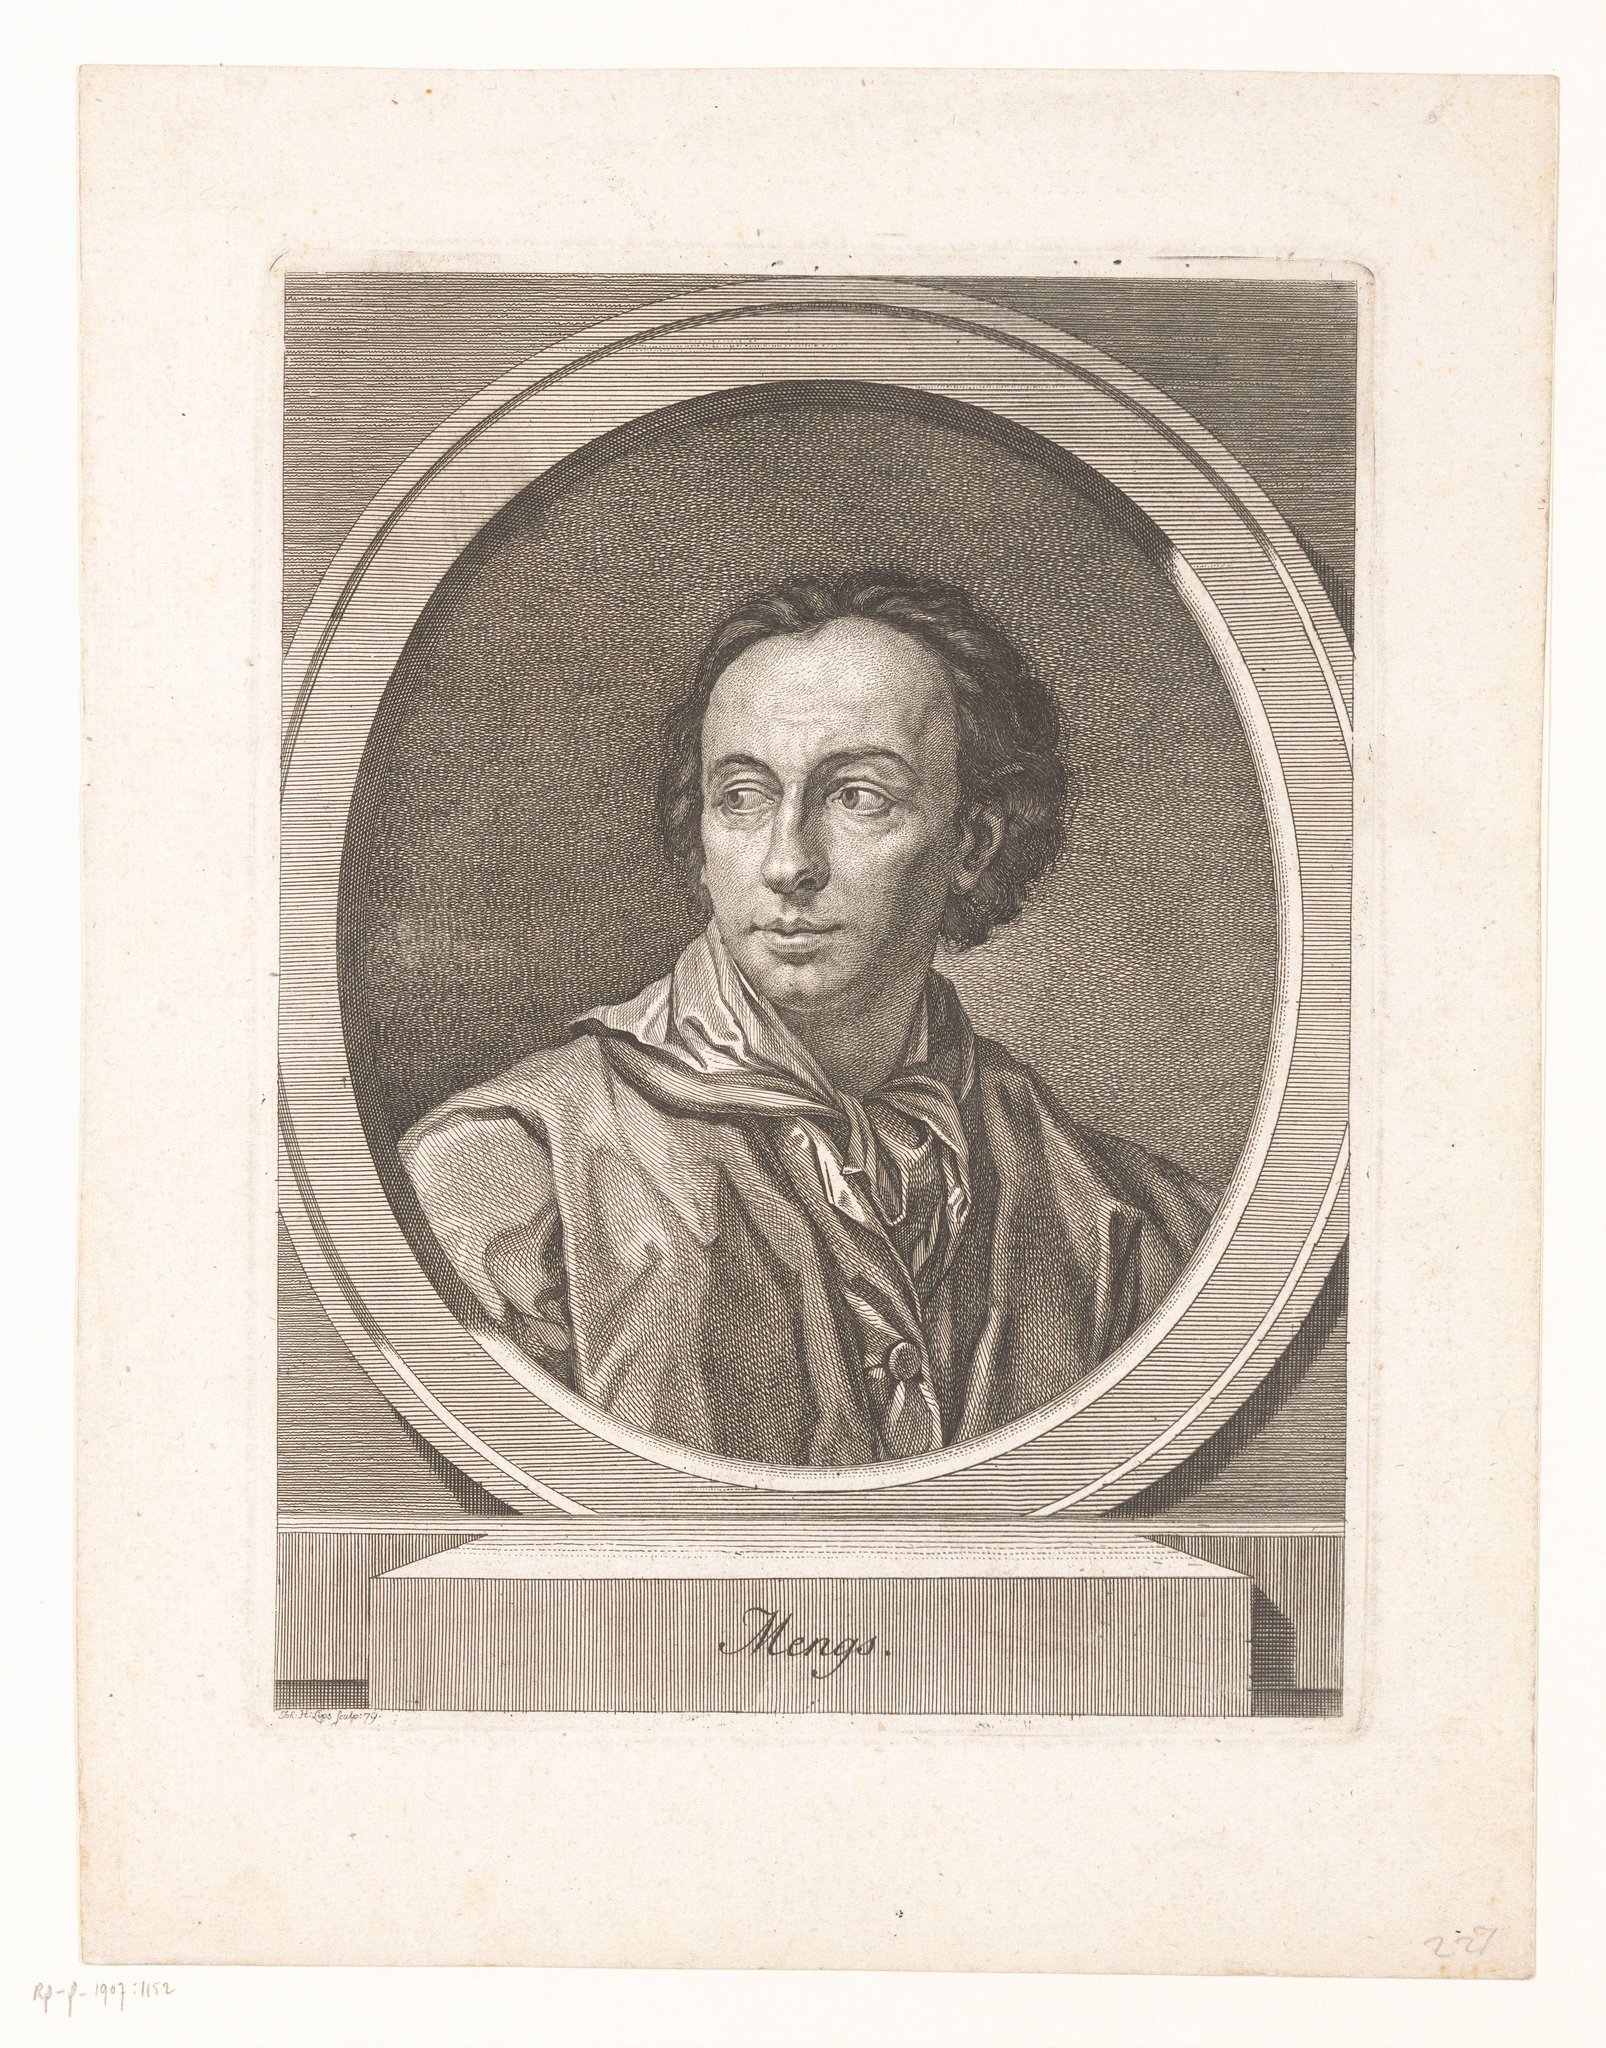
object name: print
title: Portret van Anton Raphael Mengs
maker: johann heinrich lips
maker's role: draughtsman, painter, print maker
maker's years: 1758-1817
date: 1779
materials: paper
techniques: etching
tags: painter, draughtsman, anton raphael mengs, historical persons, portrait, self-portrait of artist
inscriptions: collector's mark: Lugt 2228